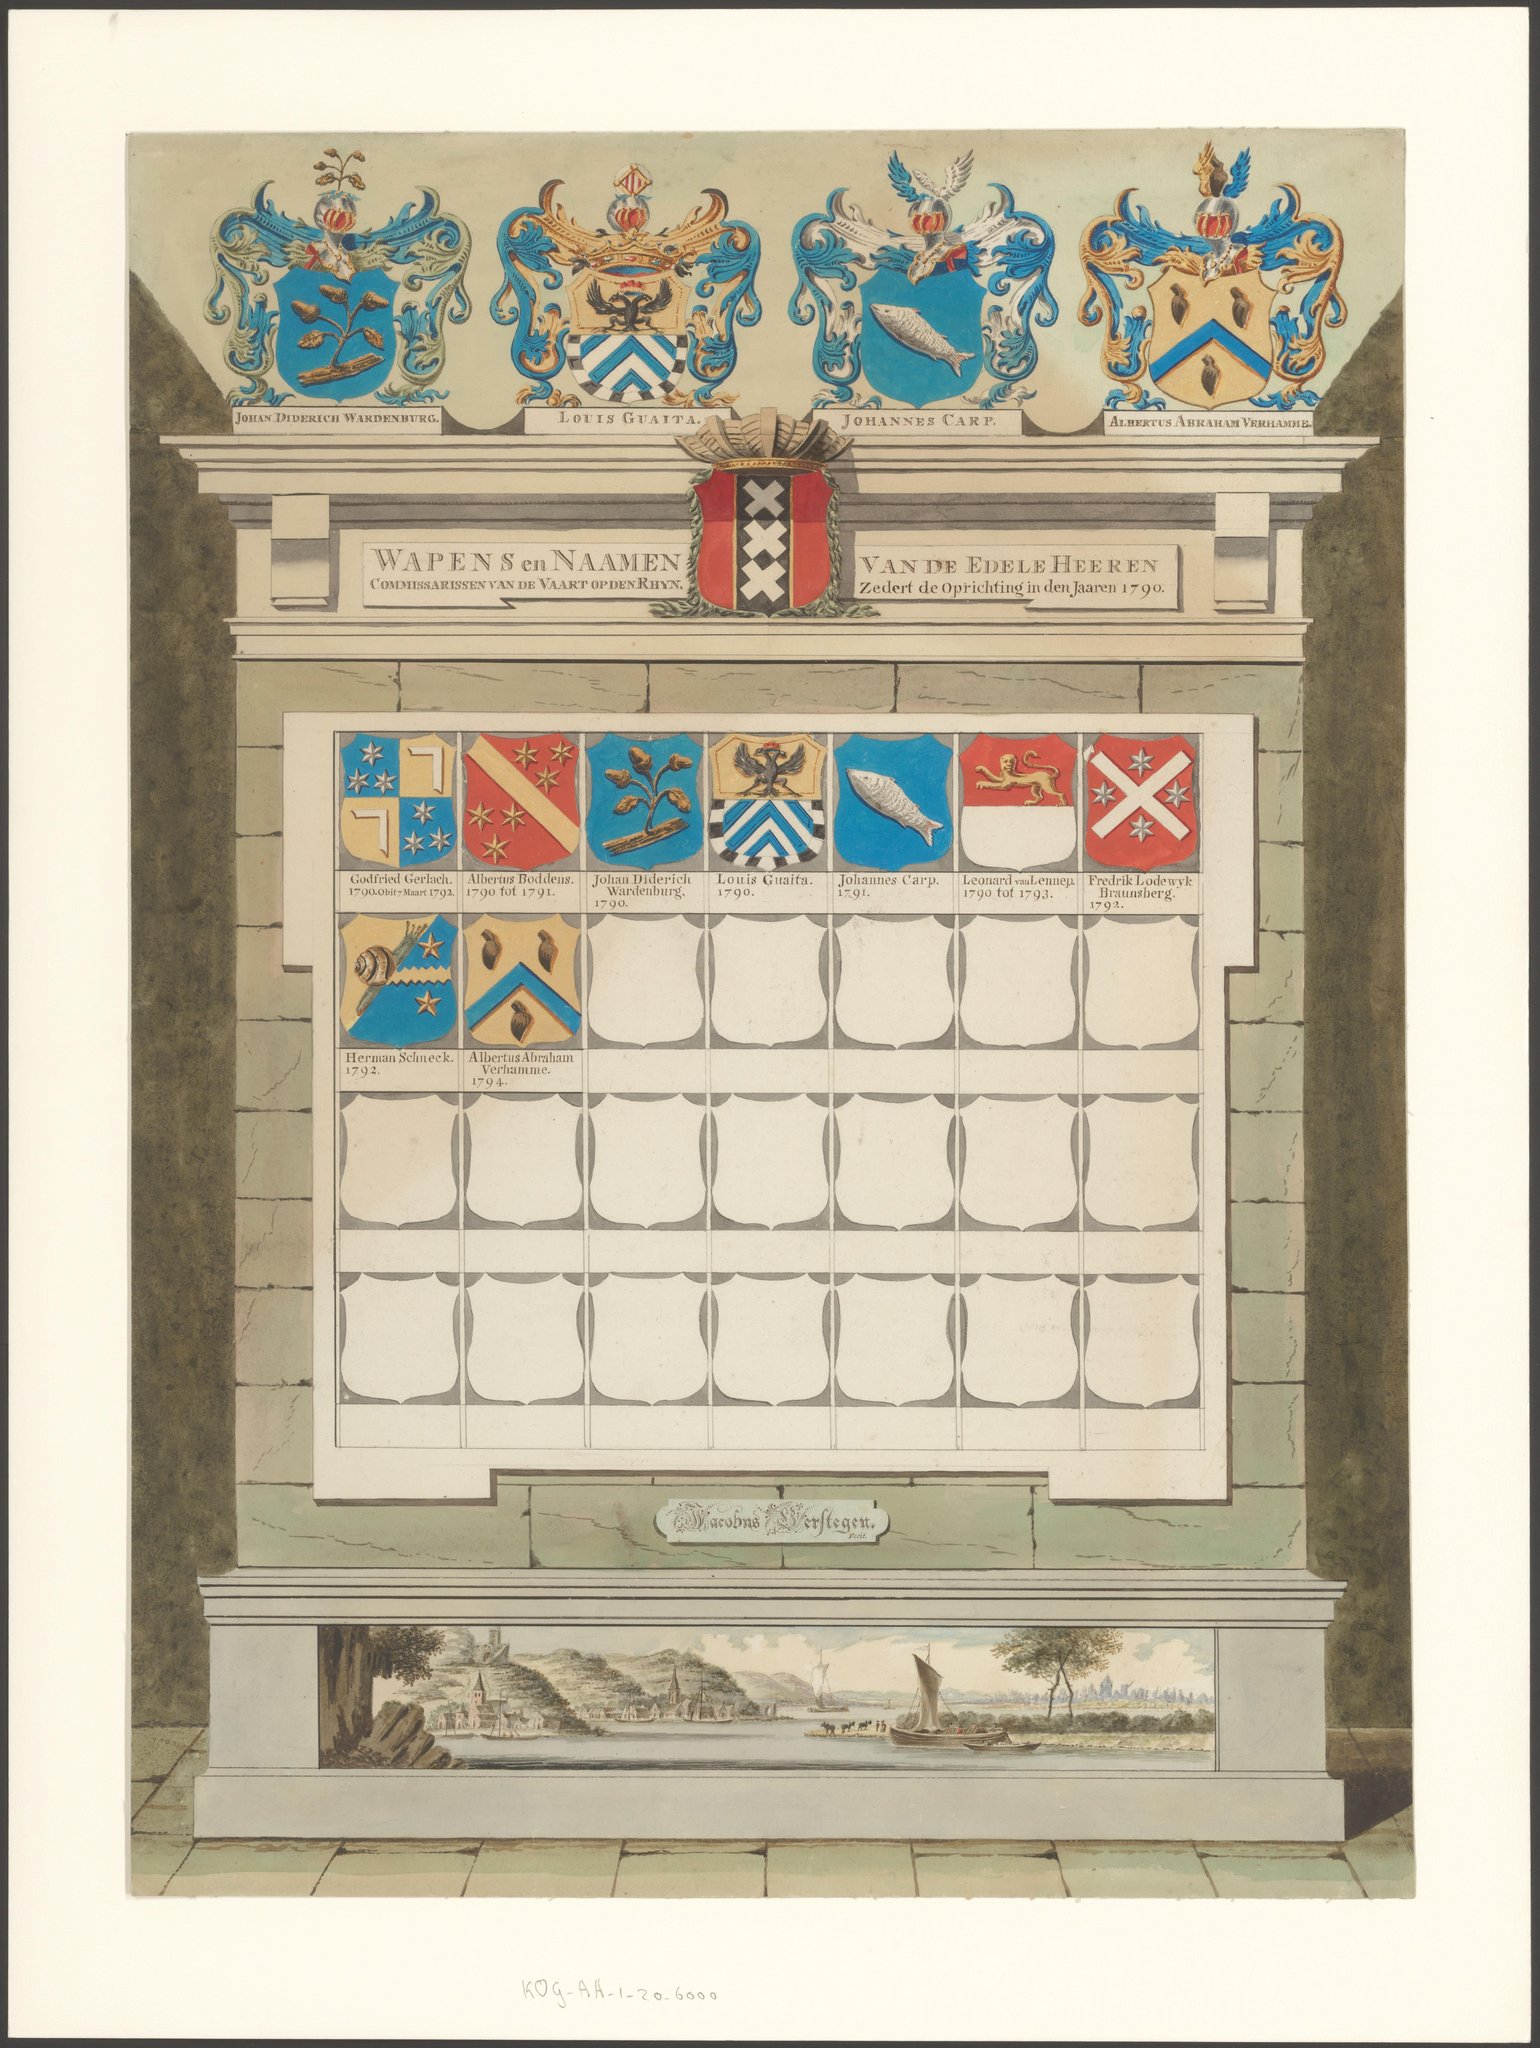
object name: drawing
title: Wapenschilden van Commissarissen over de Vaart op den Rijn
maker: jacobus versteegen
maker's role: draughtsman, print maker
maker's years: 1735-1795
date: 1745-1795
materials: paint, ink, paper, pencil, watercolor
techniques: brush, pen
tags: armorial bearing, heraldry, amsterdam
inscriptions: collector's mark: ‘392 / 20’ Lugt 1641b